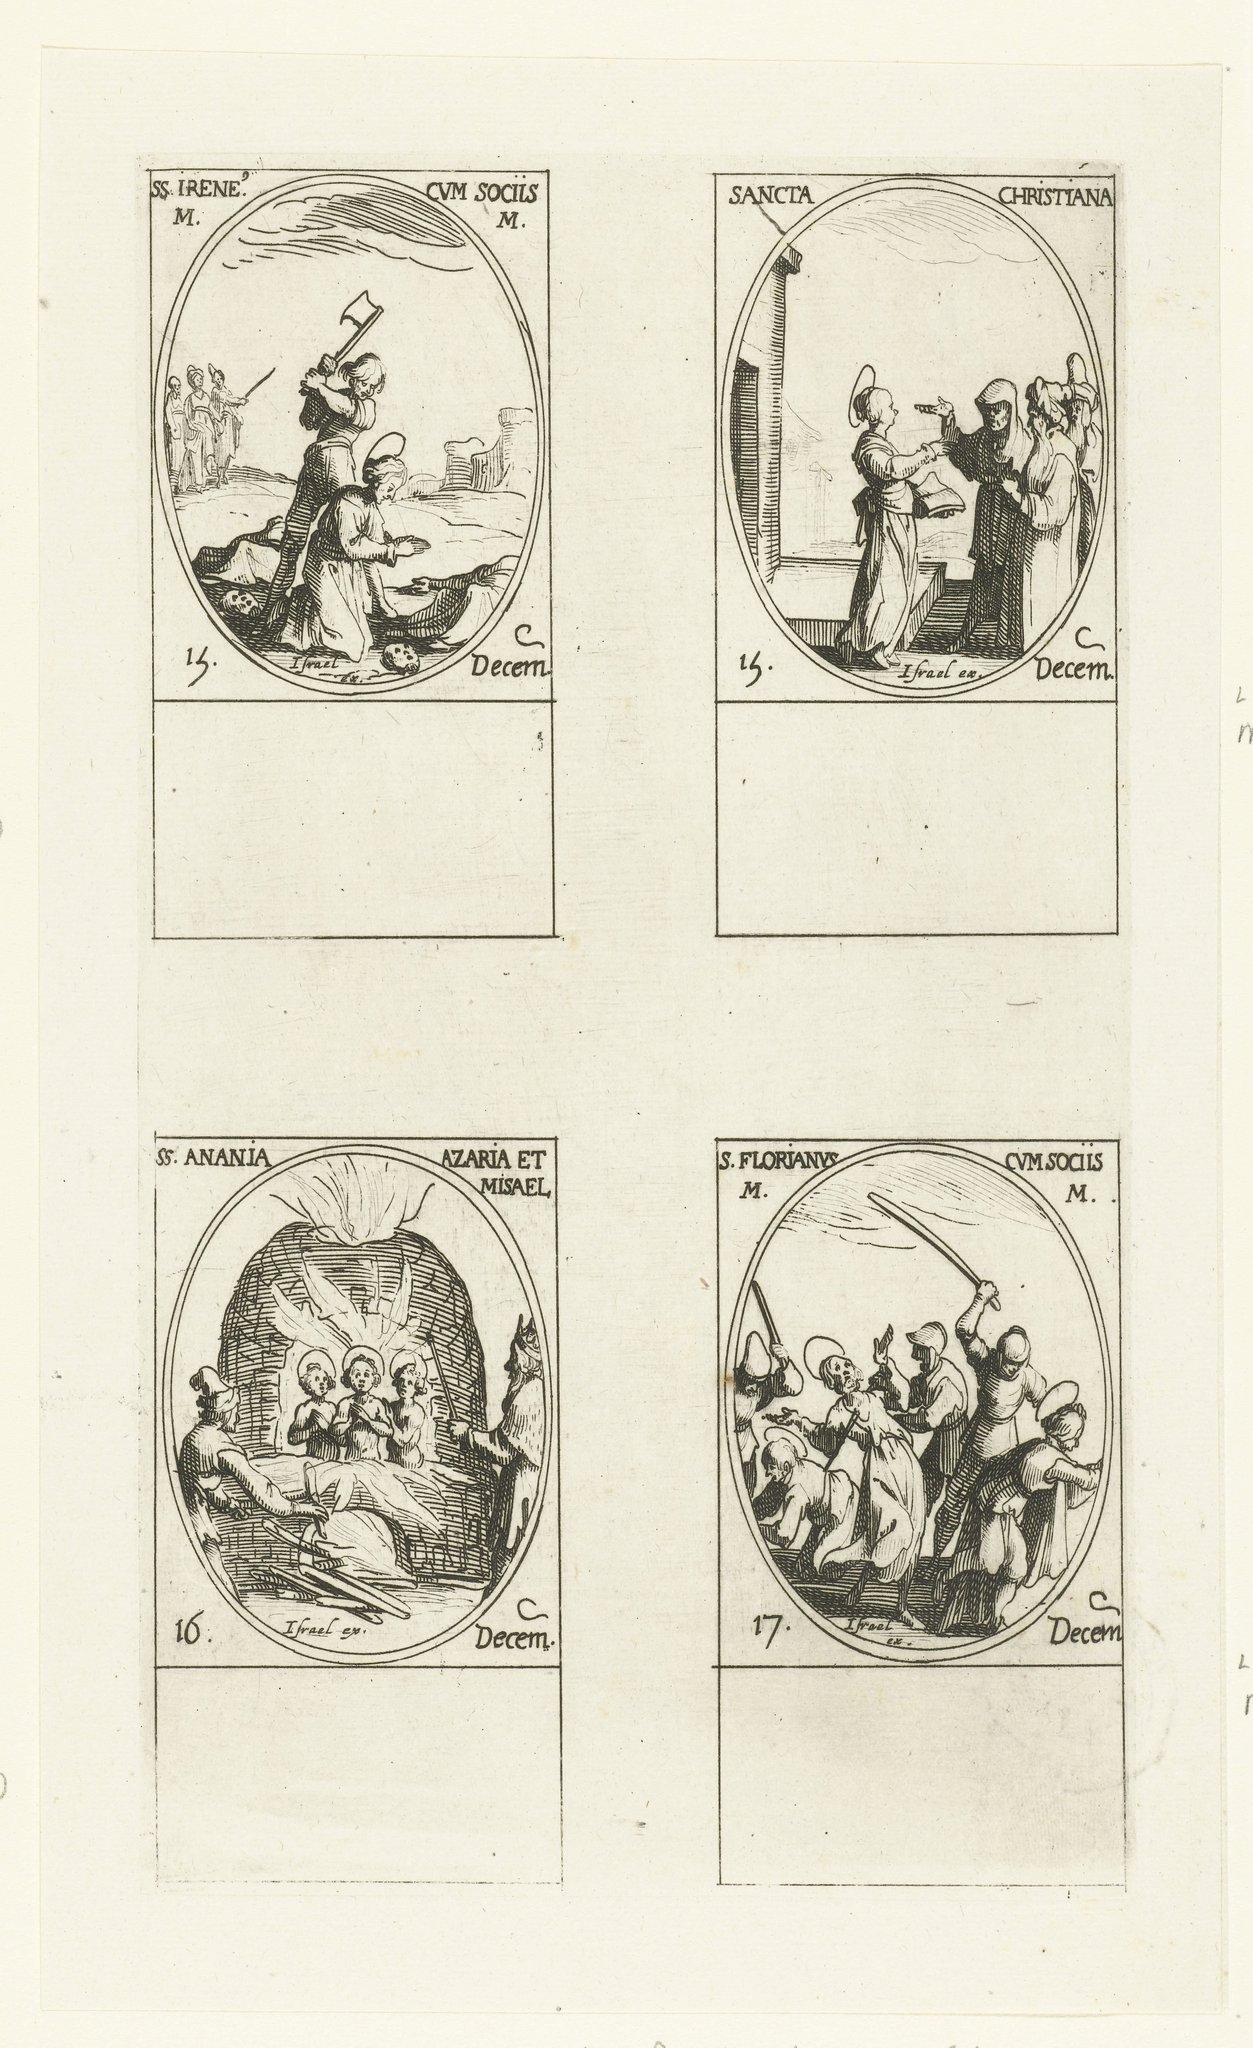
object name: print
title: Alle heiligen en de Christelijke feestdagen van het jaar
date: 1632-1636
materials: paper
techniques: etching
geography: paris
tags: the story of the three hebrews in the fiery furnace (daniel 3), female saints (with name), male saints (with name)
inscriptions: collector's mark: Lugt 240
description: Blad met vier ovale voorstellingen, elk met opschrift en datum in het Latijn: linksboven de Heilige Ireneus van Rome die onthoofd wordt, net als zijn gezellen, rechtsboven de Heilige Christiana van Georgië in gesprek met een groep mannen, linksonder de Heilige Ananias, de Heilige Azarias en de Heilige Misael van Babylon in een oven, rechtsonder de Heilige Florianus en gezellen die worden aangevallen door soldaten met stokken. Deze prent is onderdeel van een serie prenten met voorstellingen van de heiligen en de christelijke feestdagen van het jaar. Er zijn steeds vier scènes van één plaat op één blad gedrukt. Inclusief bijbehorend titelblad en frontispice gaat het in totaal om 124 platen (490 voorstellingen). De drie platen met de laatste 12 scènes (de veranderlijke christelijke feestdagen) zijn in de derde staat versneden tot 12 kleine plaatjes, en met een apart titelblad uitgegeven.